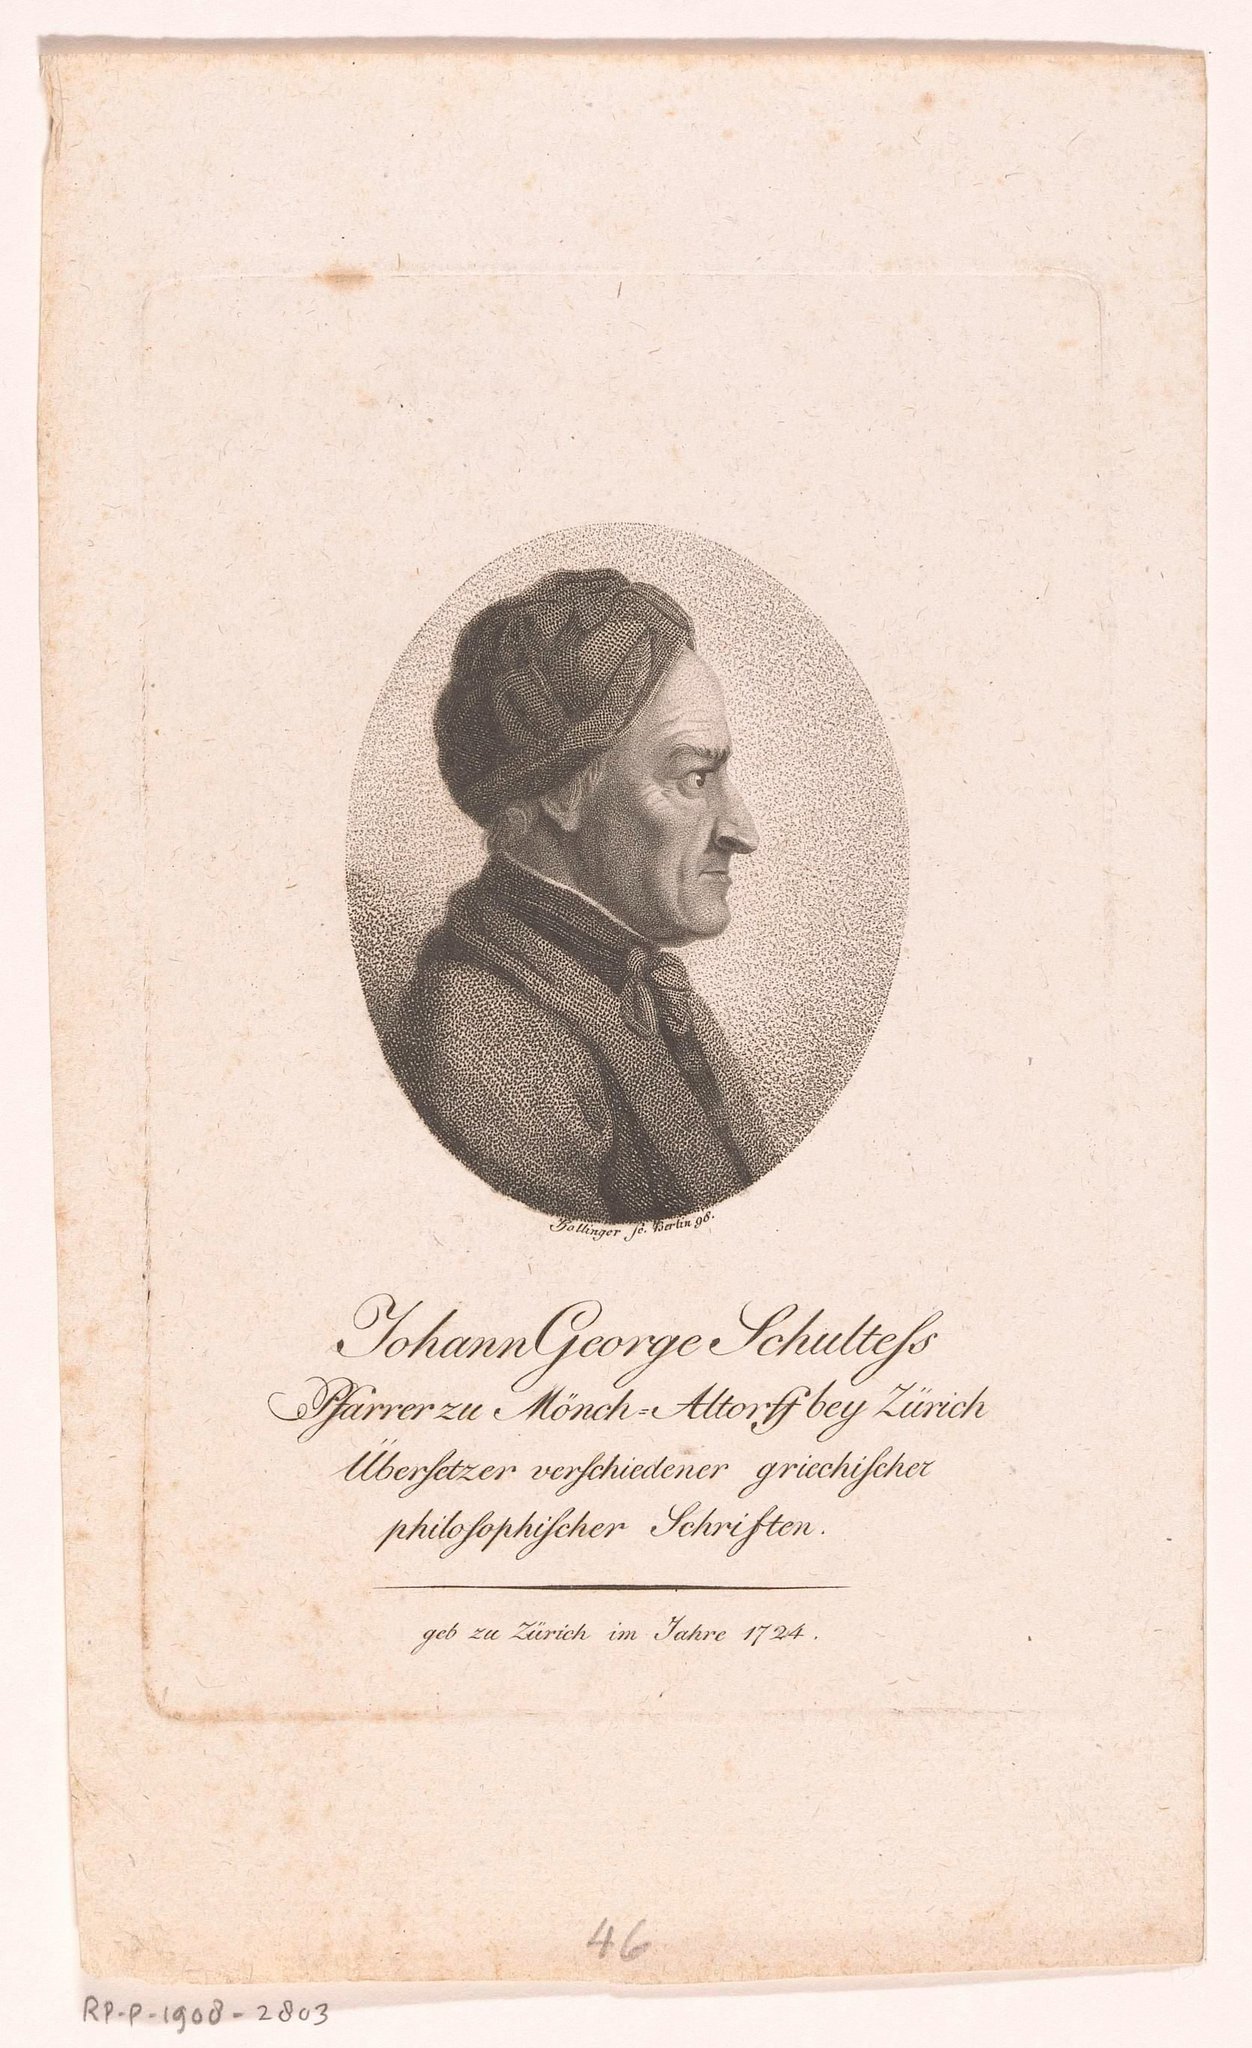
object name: print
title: Portret van Johann Georg Schulthess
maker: friedrich wilhelm bollinger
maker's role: print maker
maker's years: 1777-1825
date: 1798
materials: paper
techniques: stippling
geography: berlin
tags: historical persons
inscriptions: collector's mark: Lugt 2228